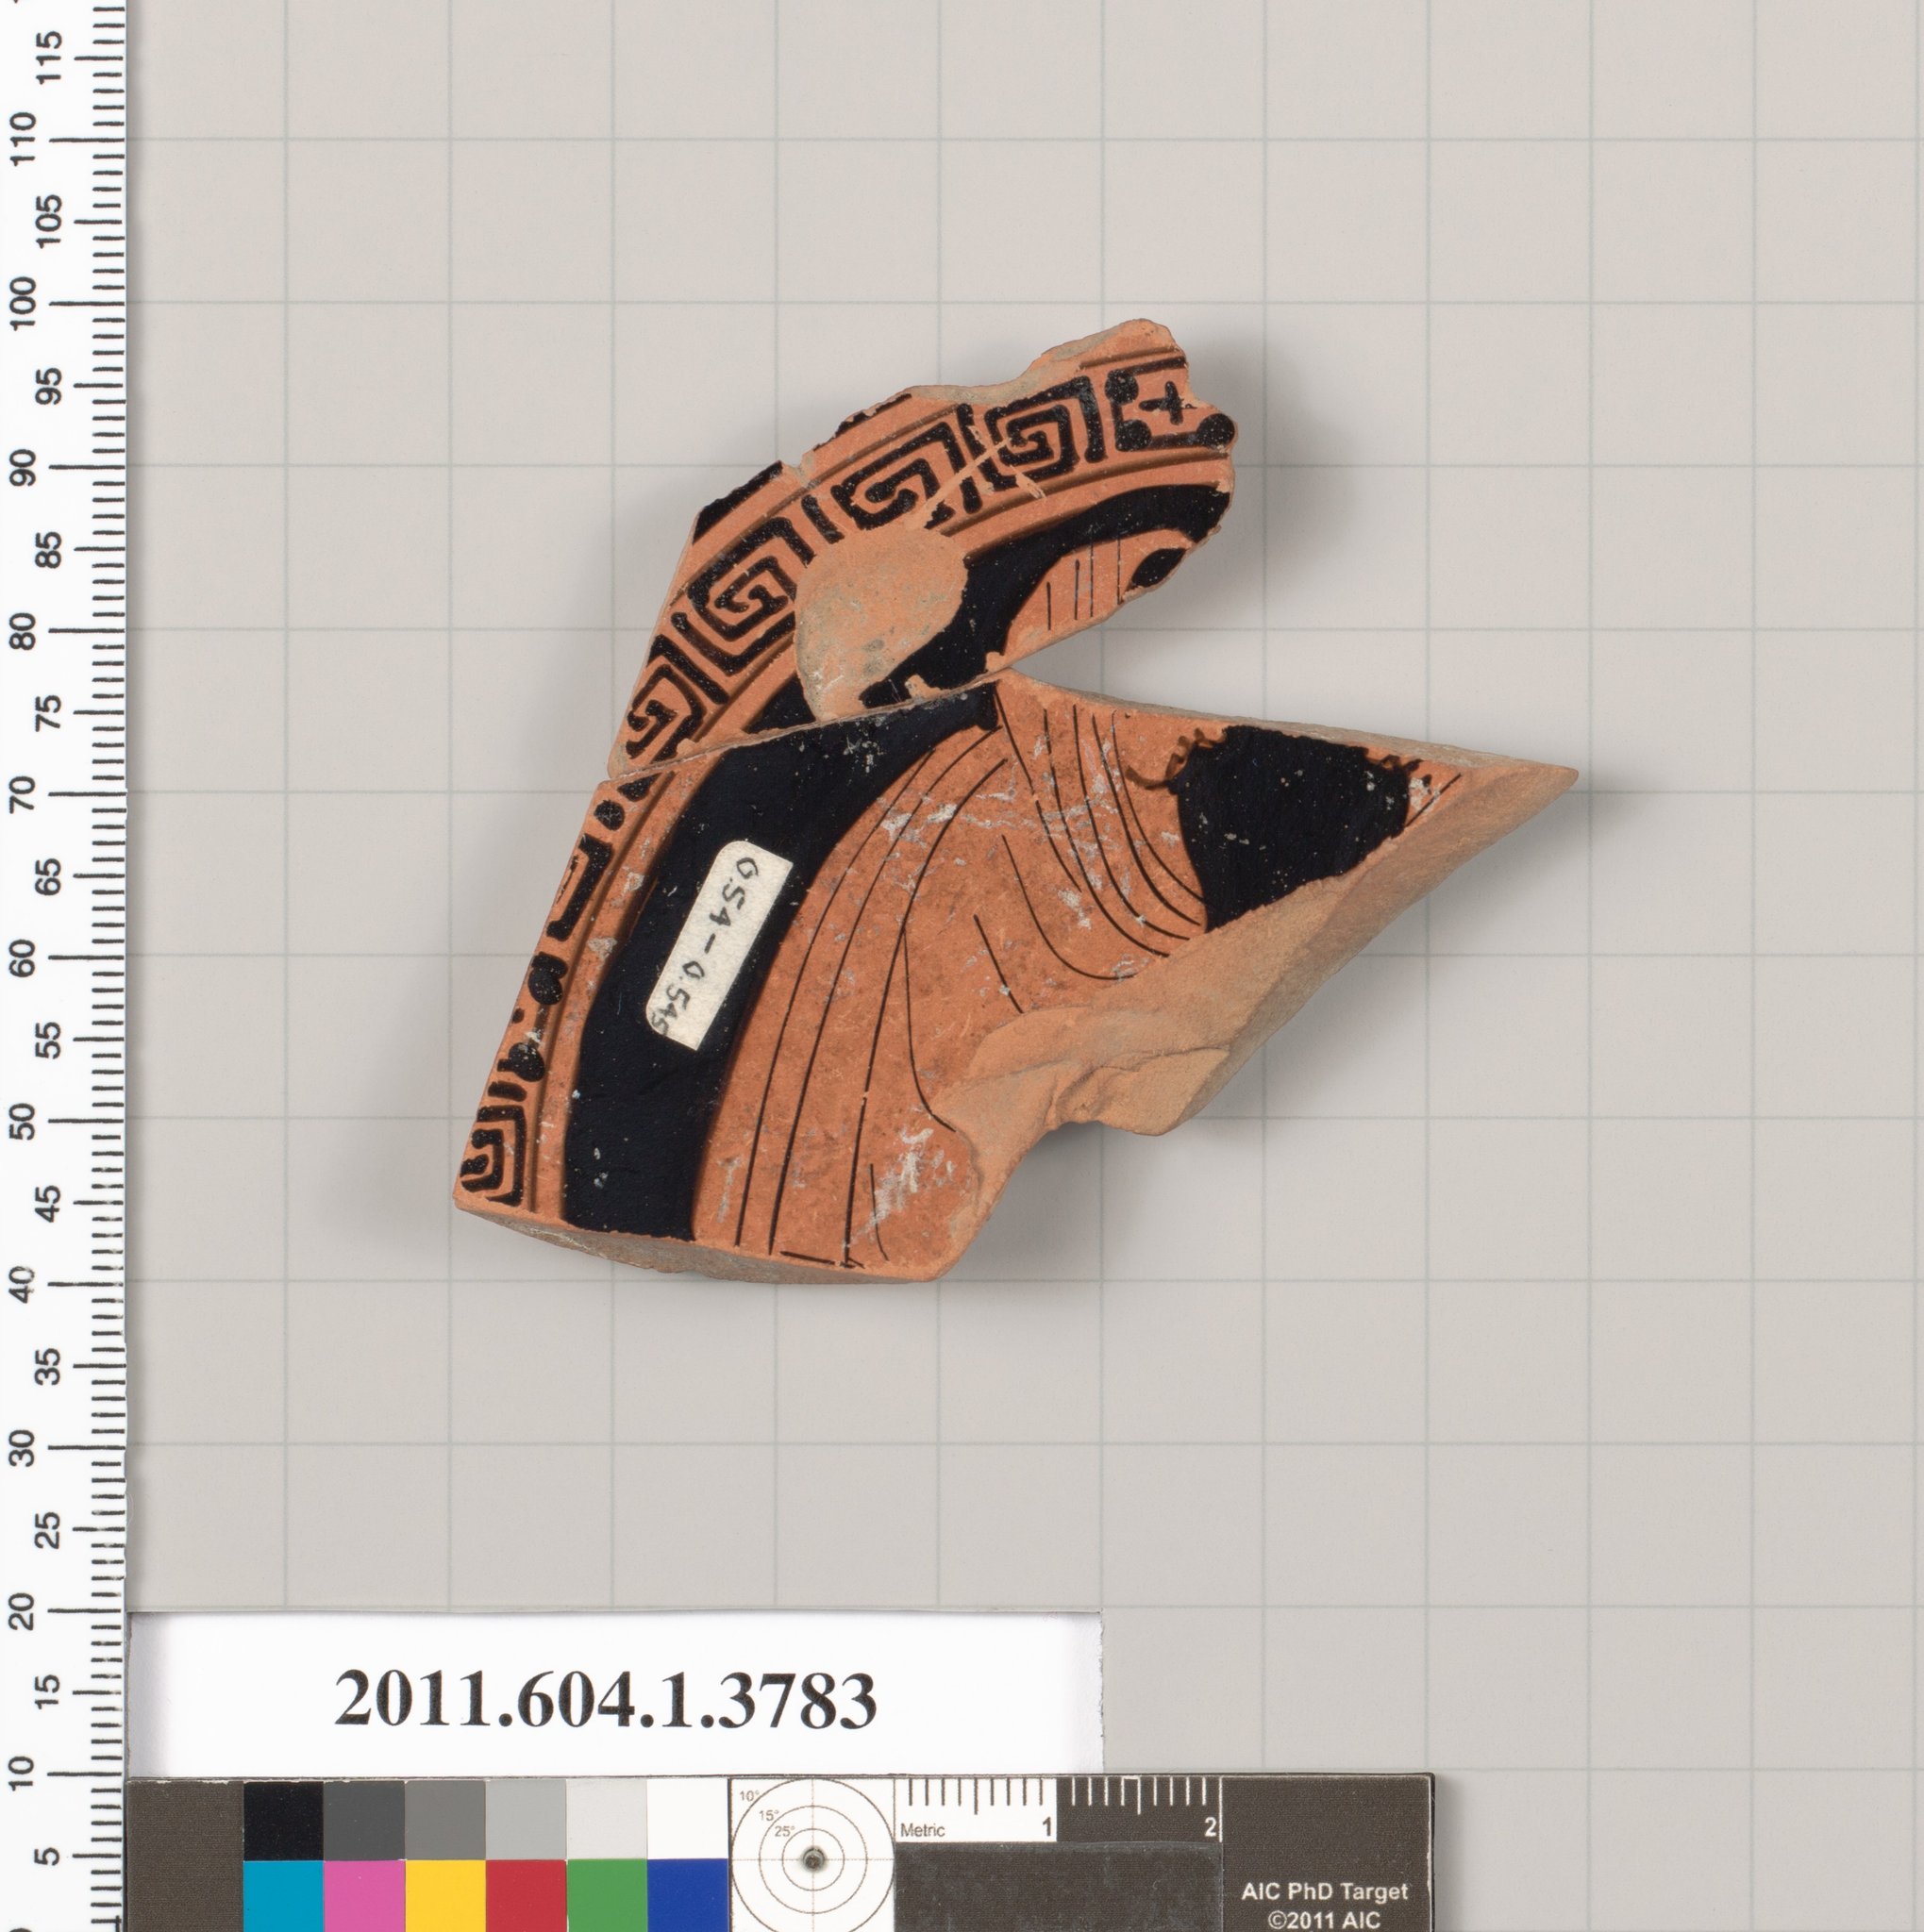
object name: kylix fragment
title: Terracotta fragment of a kylix (drinking cup)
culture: greek, attic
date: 475-451 BCE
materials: terracotta